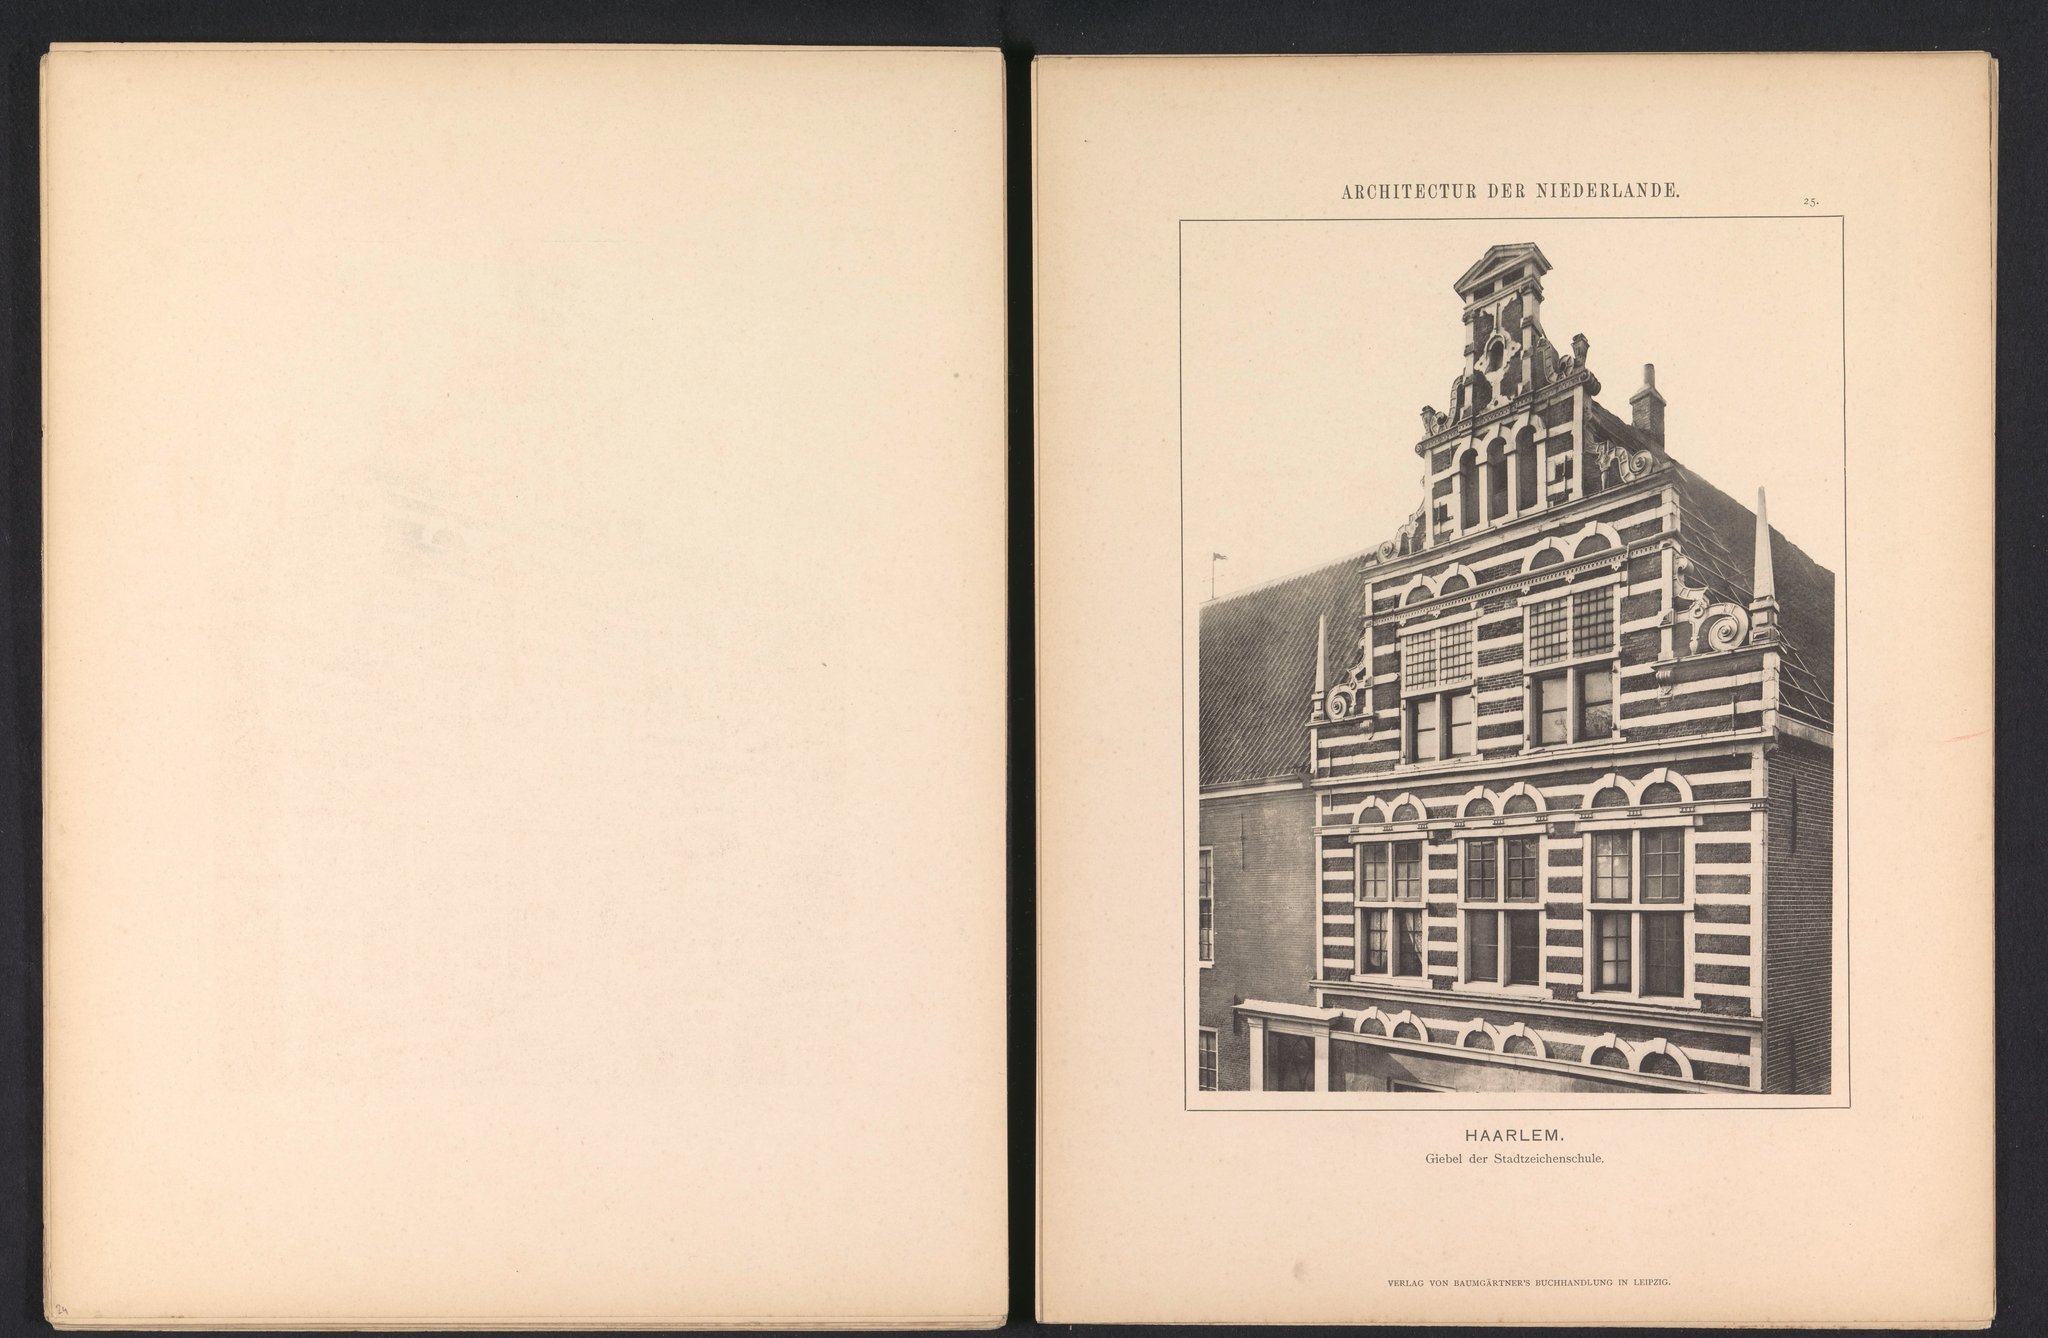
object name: page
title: Haarlem. Giebel der Stadtzeichenschule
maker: Anonymous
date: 1884-1894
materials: paper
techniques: photograph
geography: leipzig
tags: decorated gable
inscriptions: number: ‘25.’